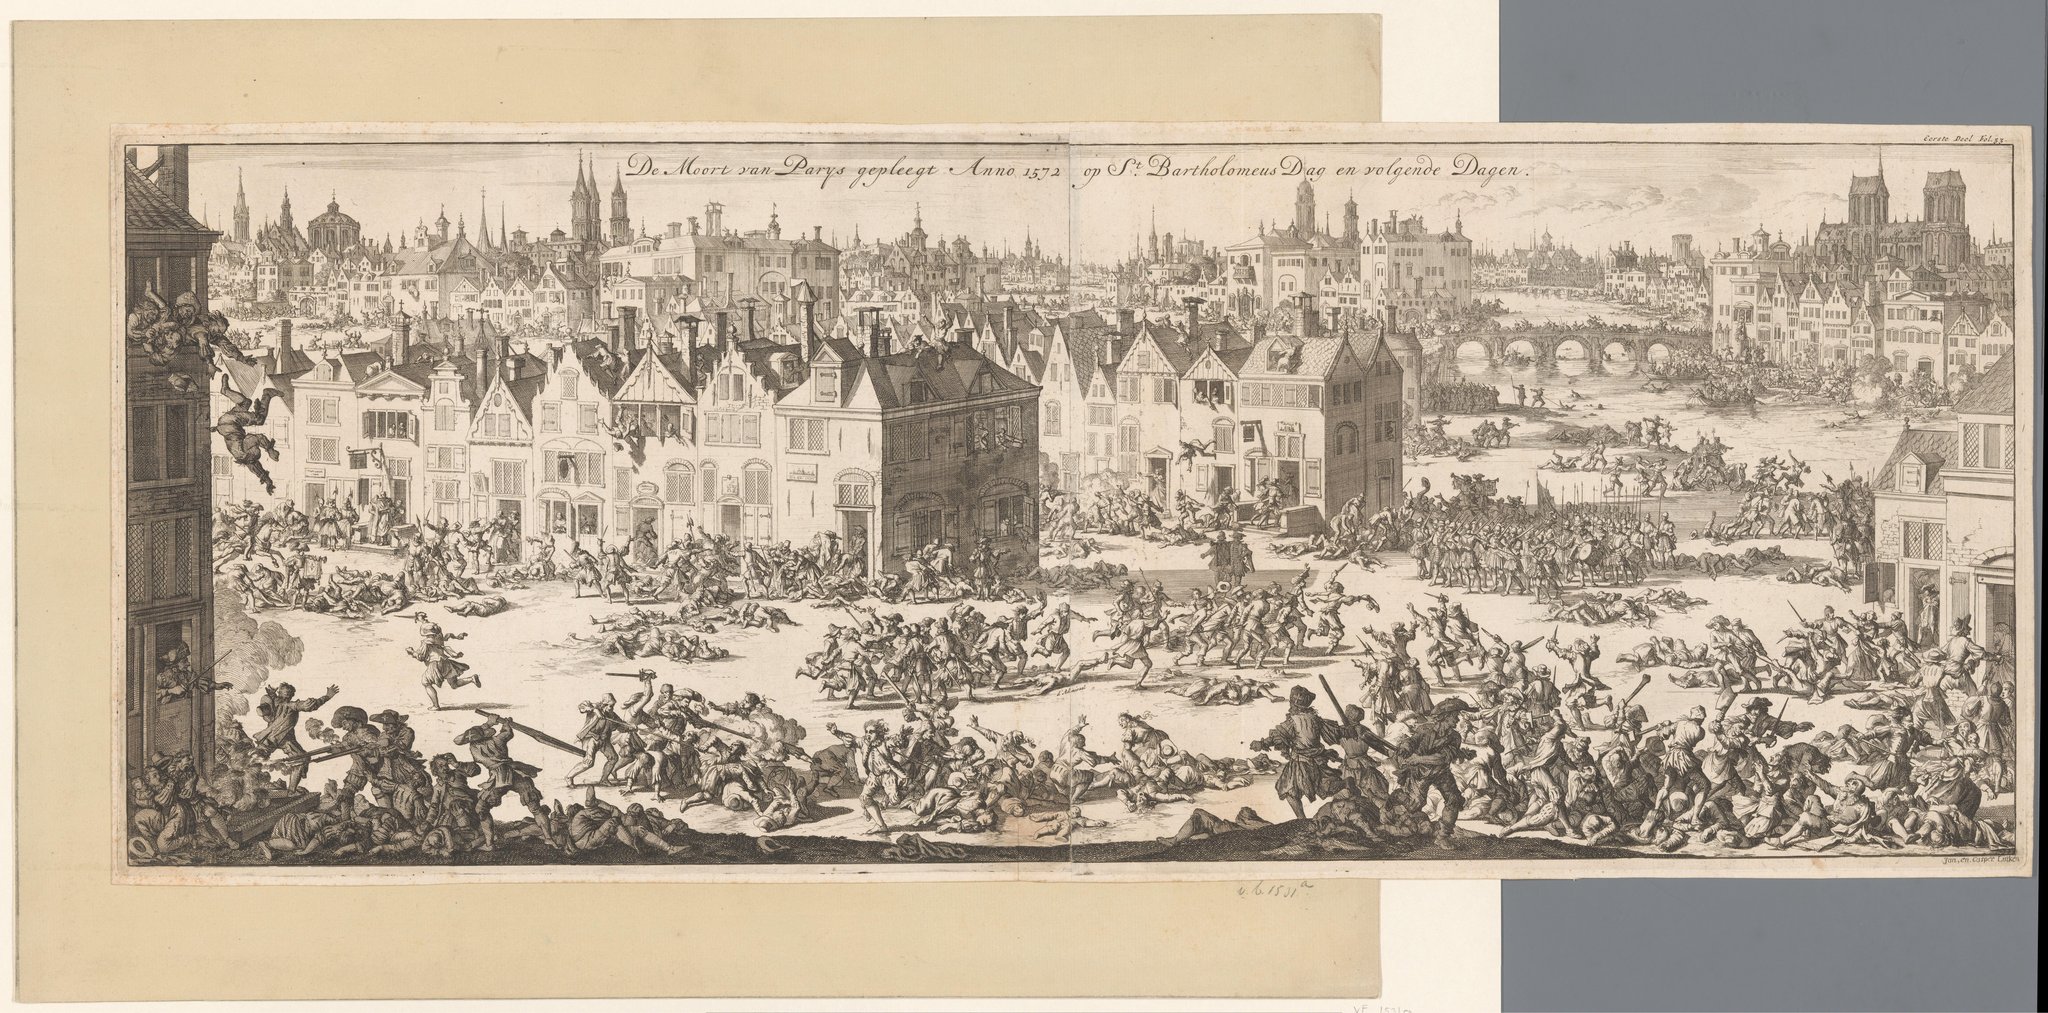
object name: print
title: De Moort van Parys gepleegt Anno 1572 op St. Bartholomeus Dag en volgende Dagen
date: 1696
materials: paper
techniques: etching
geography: amsterdam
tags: paris, politician, gaspard de coligny (ii), massacre ~ war, persecution of believers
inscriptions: collector's mark: Lugt 2228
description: Weidse voorstelling van de moordpartijen tijdens de Bartholomeüsnacht van 23 op 24 augustus 1572, te Parijs. Prent rechtsboven gemerkt: Eerste Deel Fol. 33.